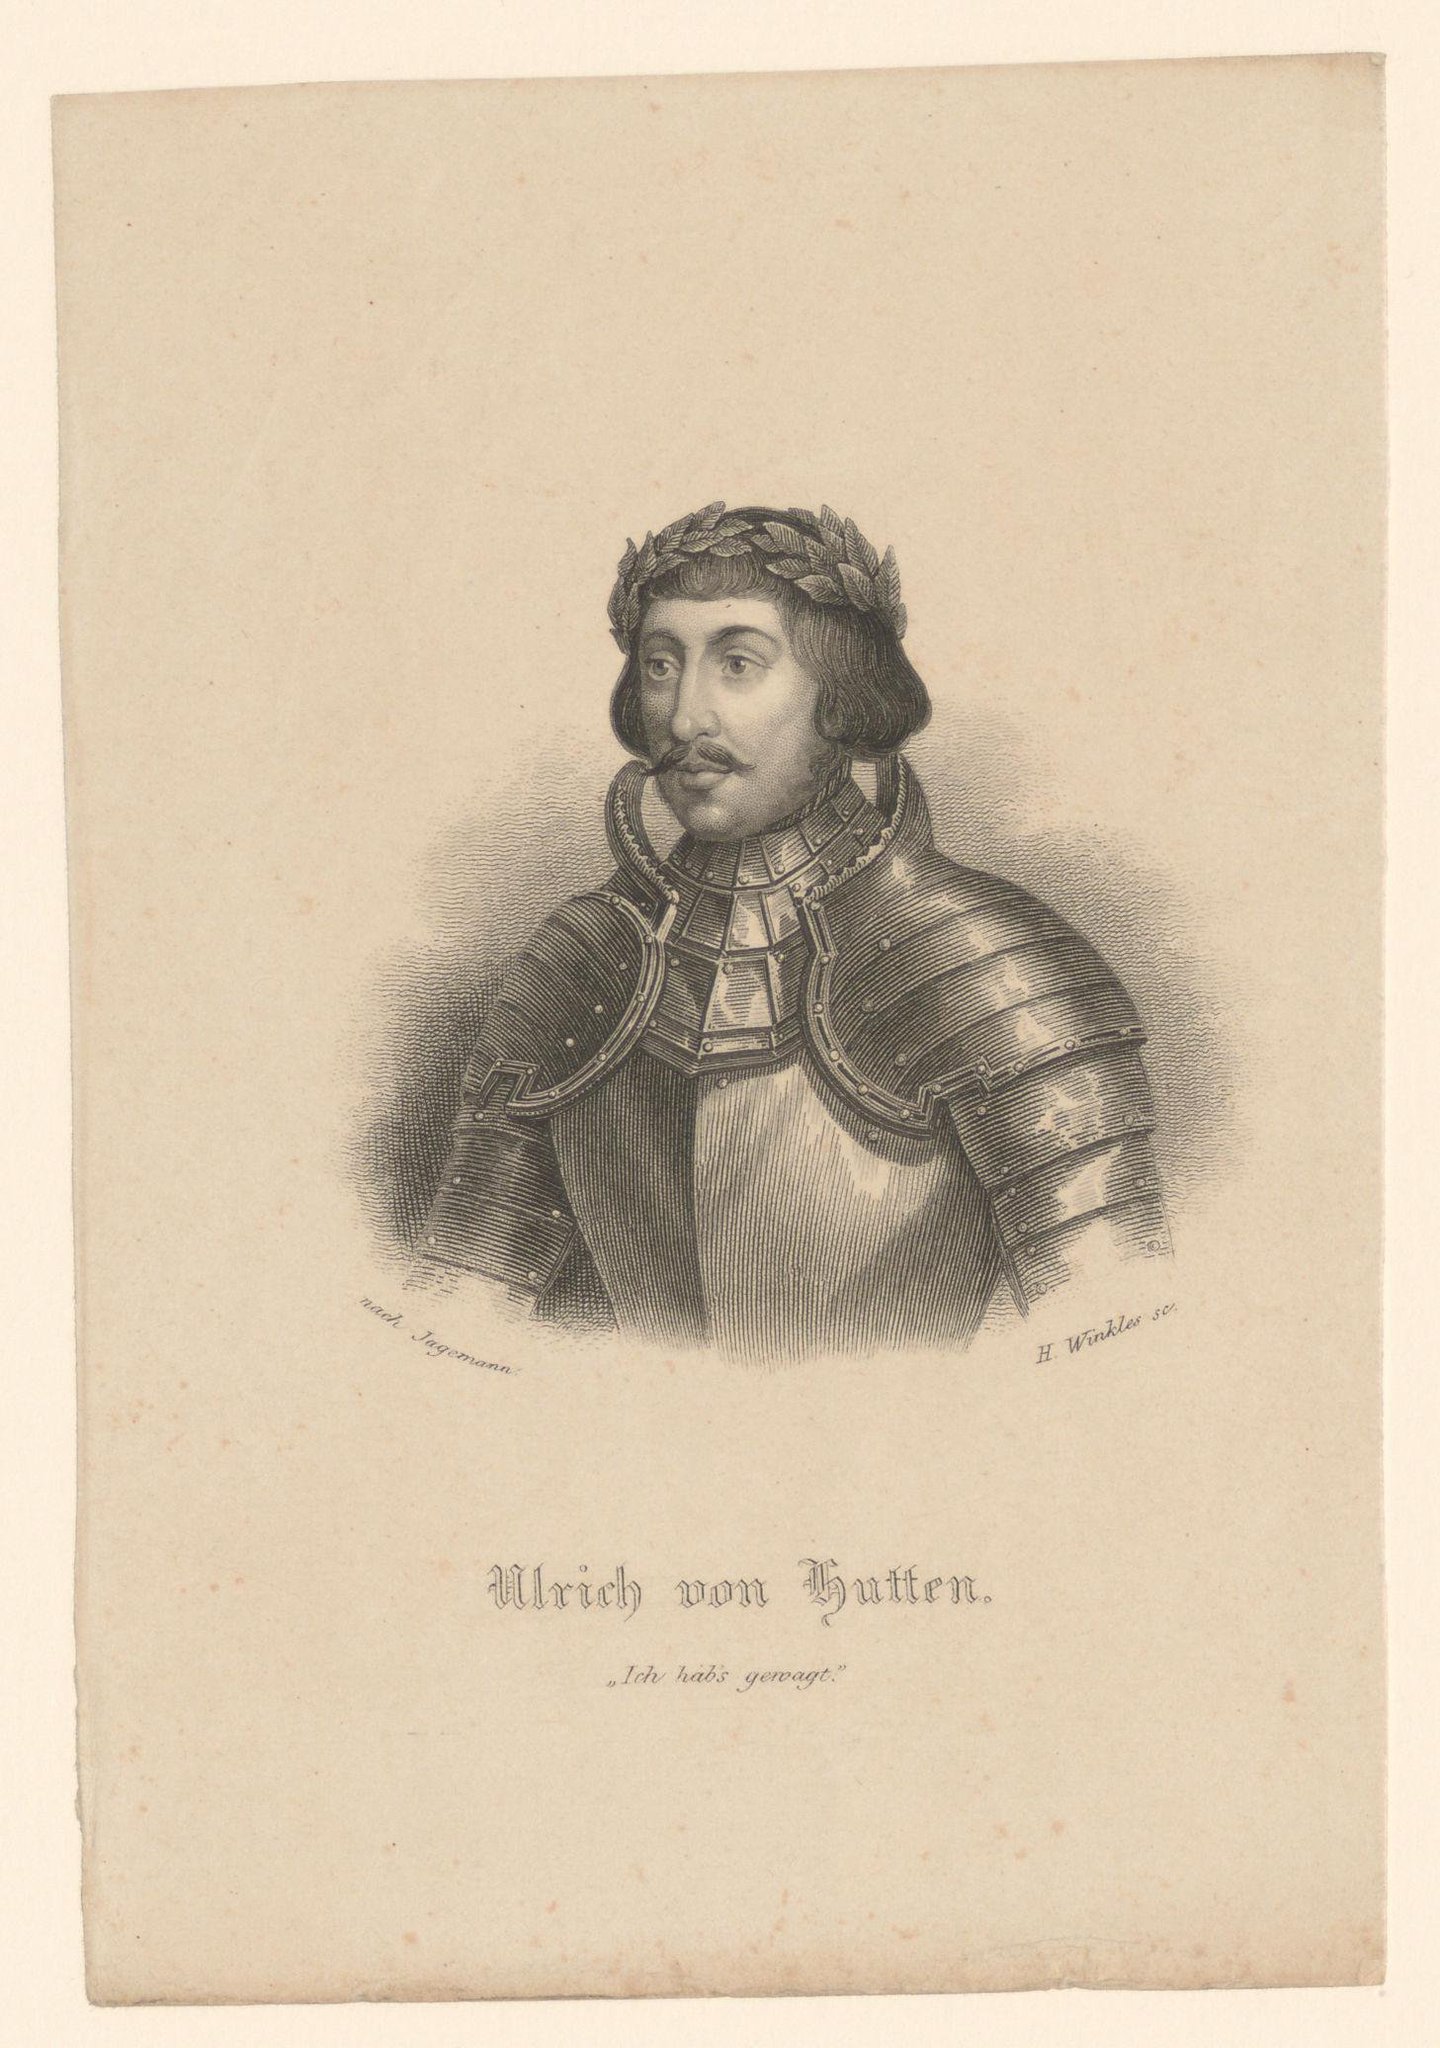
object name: print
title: Ulrich von Hutten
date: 1824-1860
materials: paper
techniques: etching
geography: germany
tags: switzerland, politician, historical persons, portrait of a writer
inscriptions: collector's mark: Lugt 2228